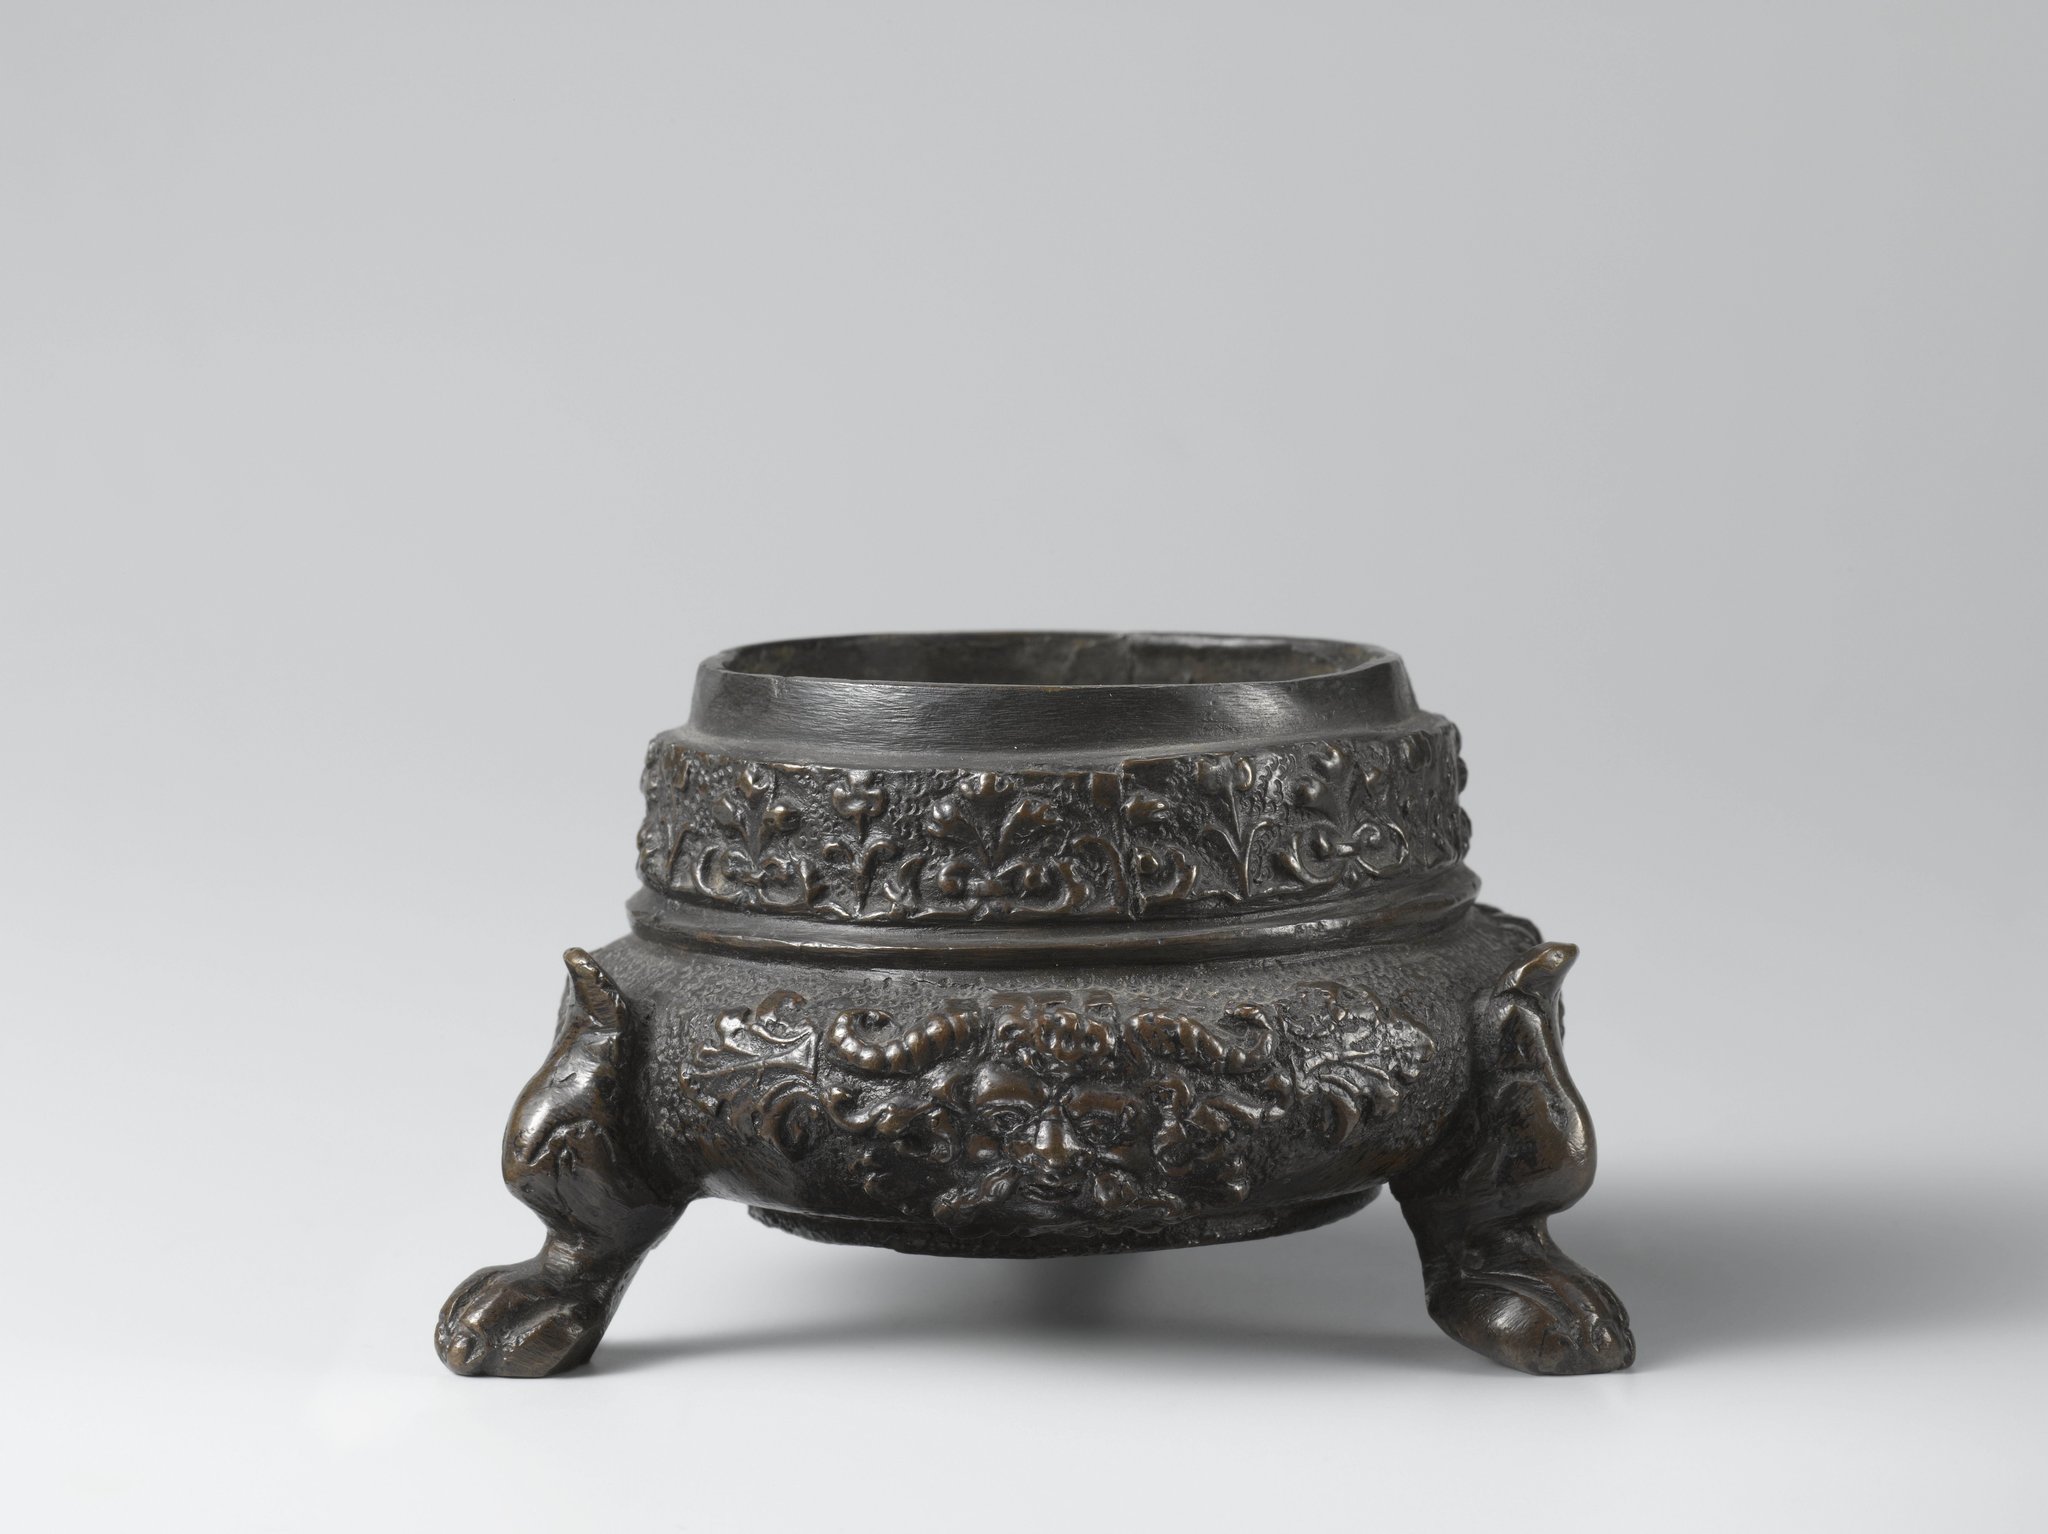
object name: sculpture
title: Potje op drie poten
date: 1500-1550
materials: bronze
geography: northern italy